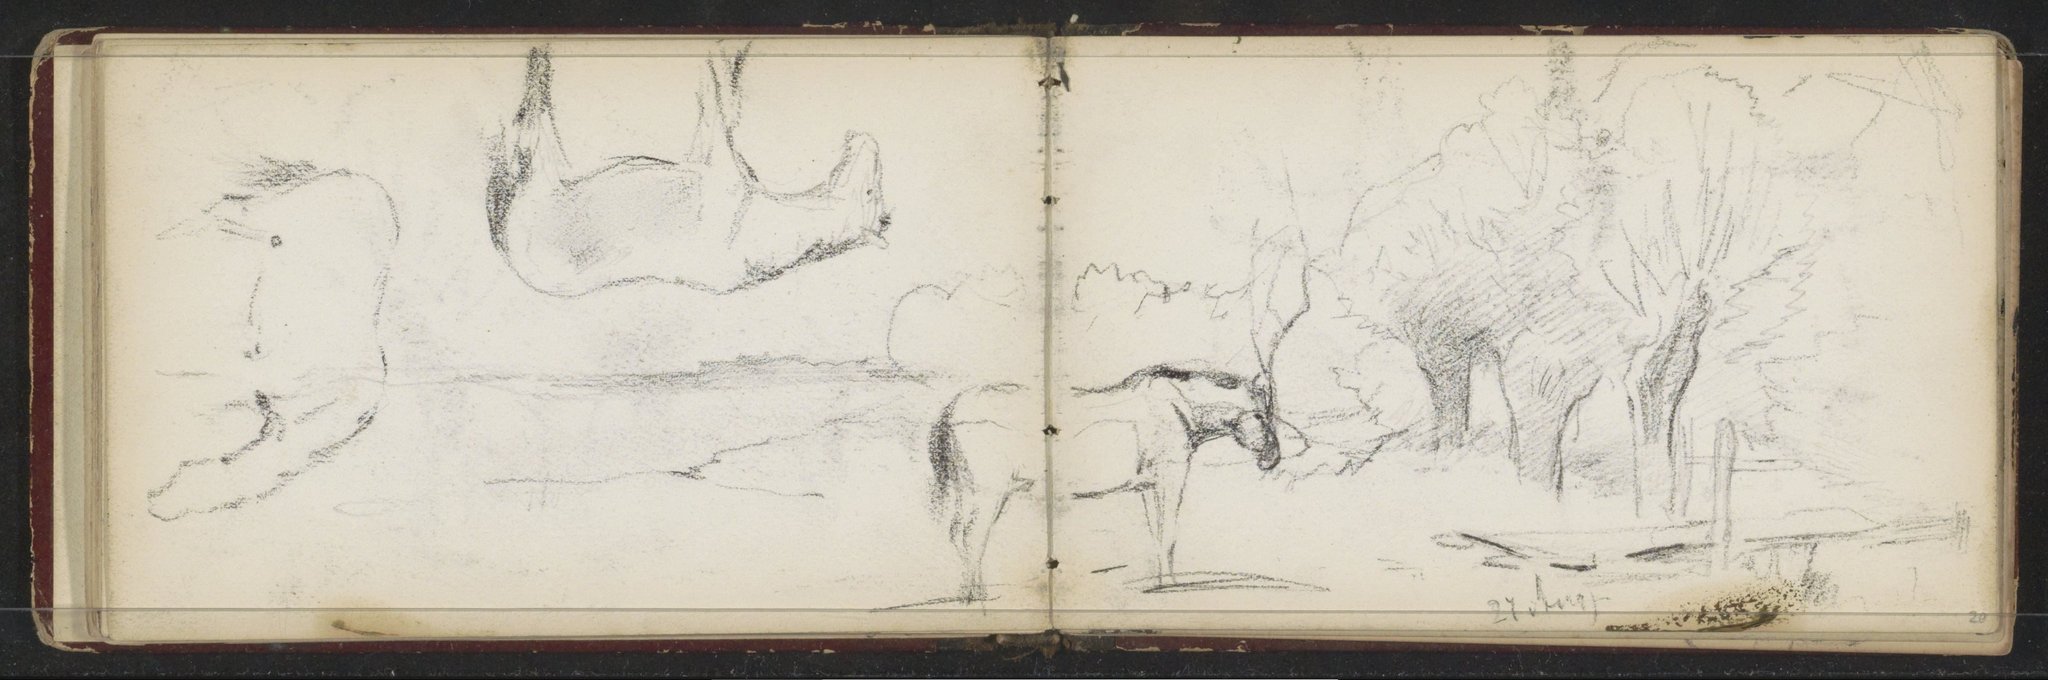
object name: sketchbook leaf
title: Paard in een weide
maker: willem cornelis rip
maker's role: draughtsman, painter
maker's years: 1856-1922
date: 1808-1891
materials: chalk, paper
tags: meadow, pasture, horse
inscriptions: date: ‘27 Aug[...]’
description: Tevens studies van paarden. Blad 19 verso en 20 recto uit een schetsboek met 28 bladen.